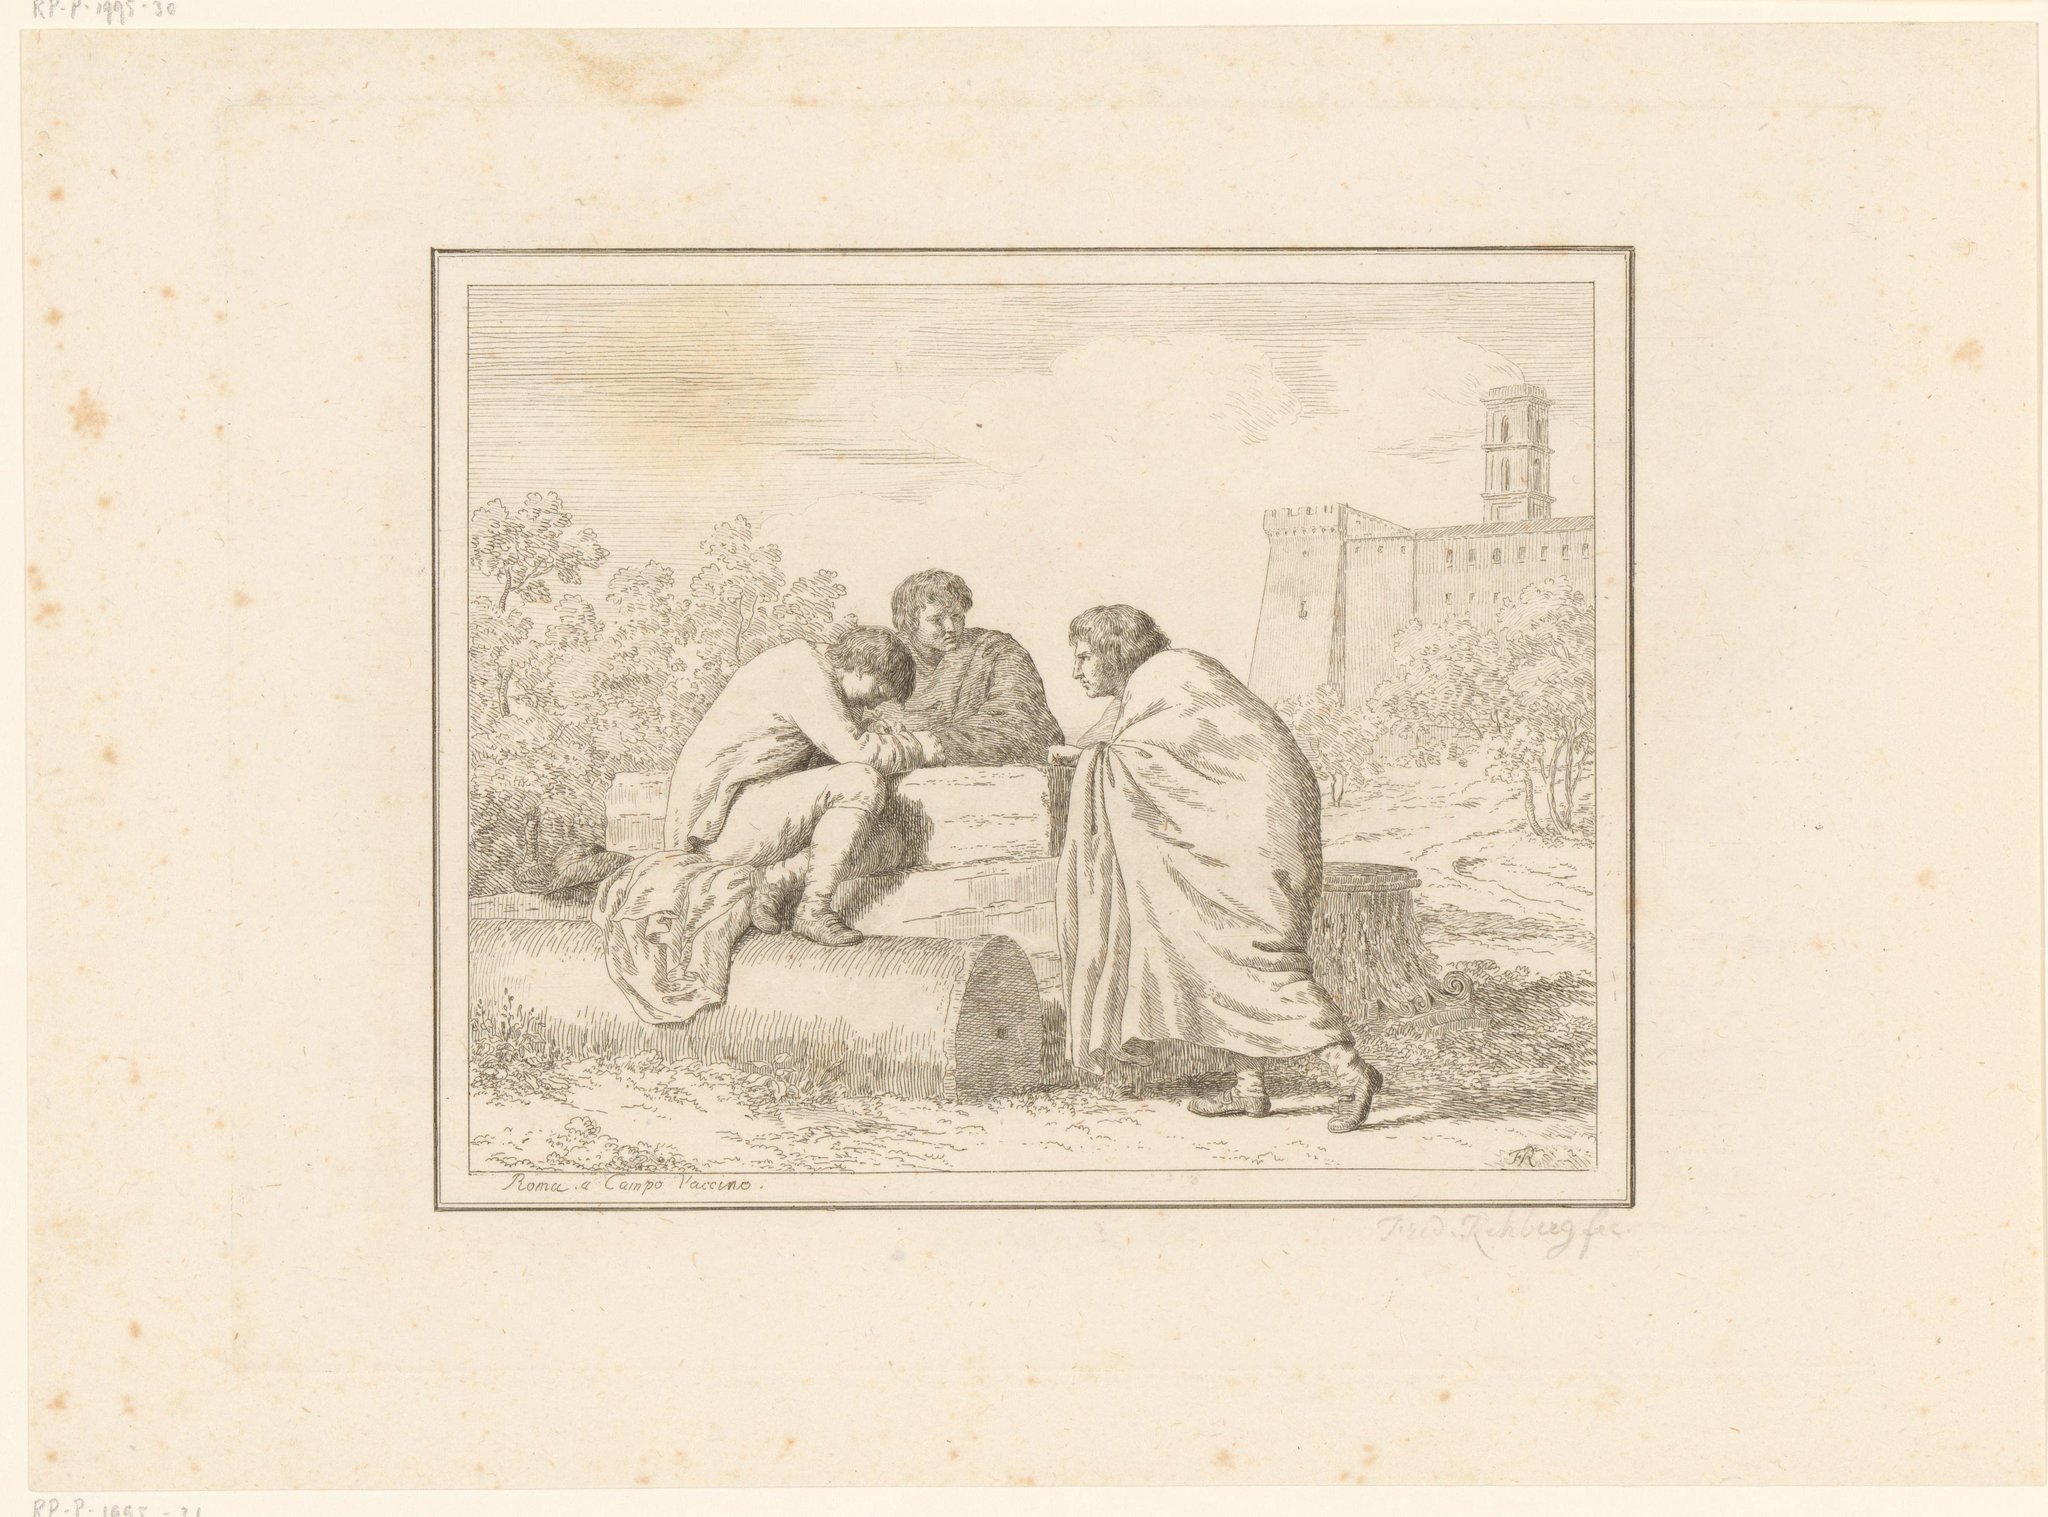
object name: print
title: Drie jongemannen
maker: friedrich rehberg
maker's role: print maker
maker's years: 1785-1835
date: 1793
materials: paper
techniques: etching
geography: germany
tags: debate, discussion (~ meeting), rome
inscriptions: date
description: No.4 uit de serie "Figure prese dal vero, ed incise a aqua forte, de Federico Rehberg, Roma, 1793". Drie mannen in toga's, discussierend op het Campo Paccino in Rome.